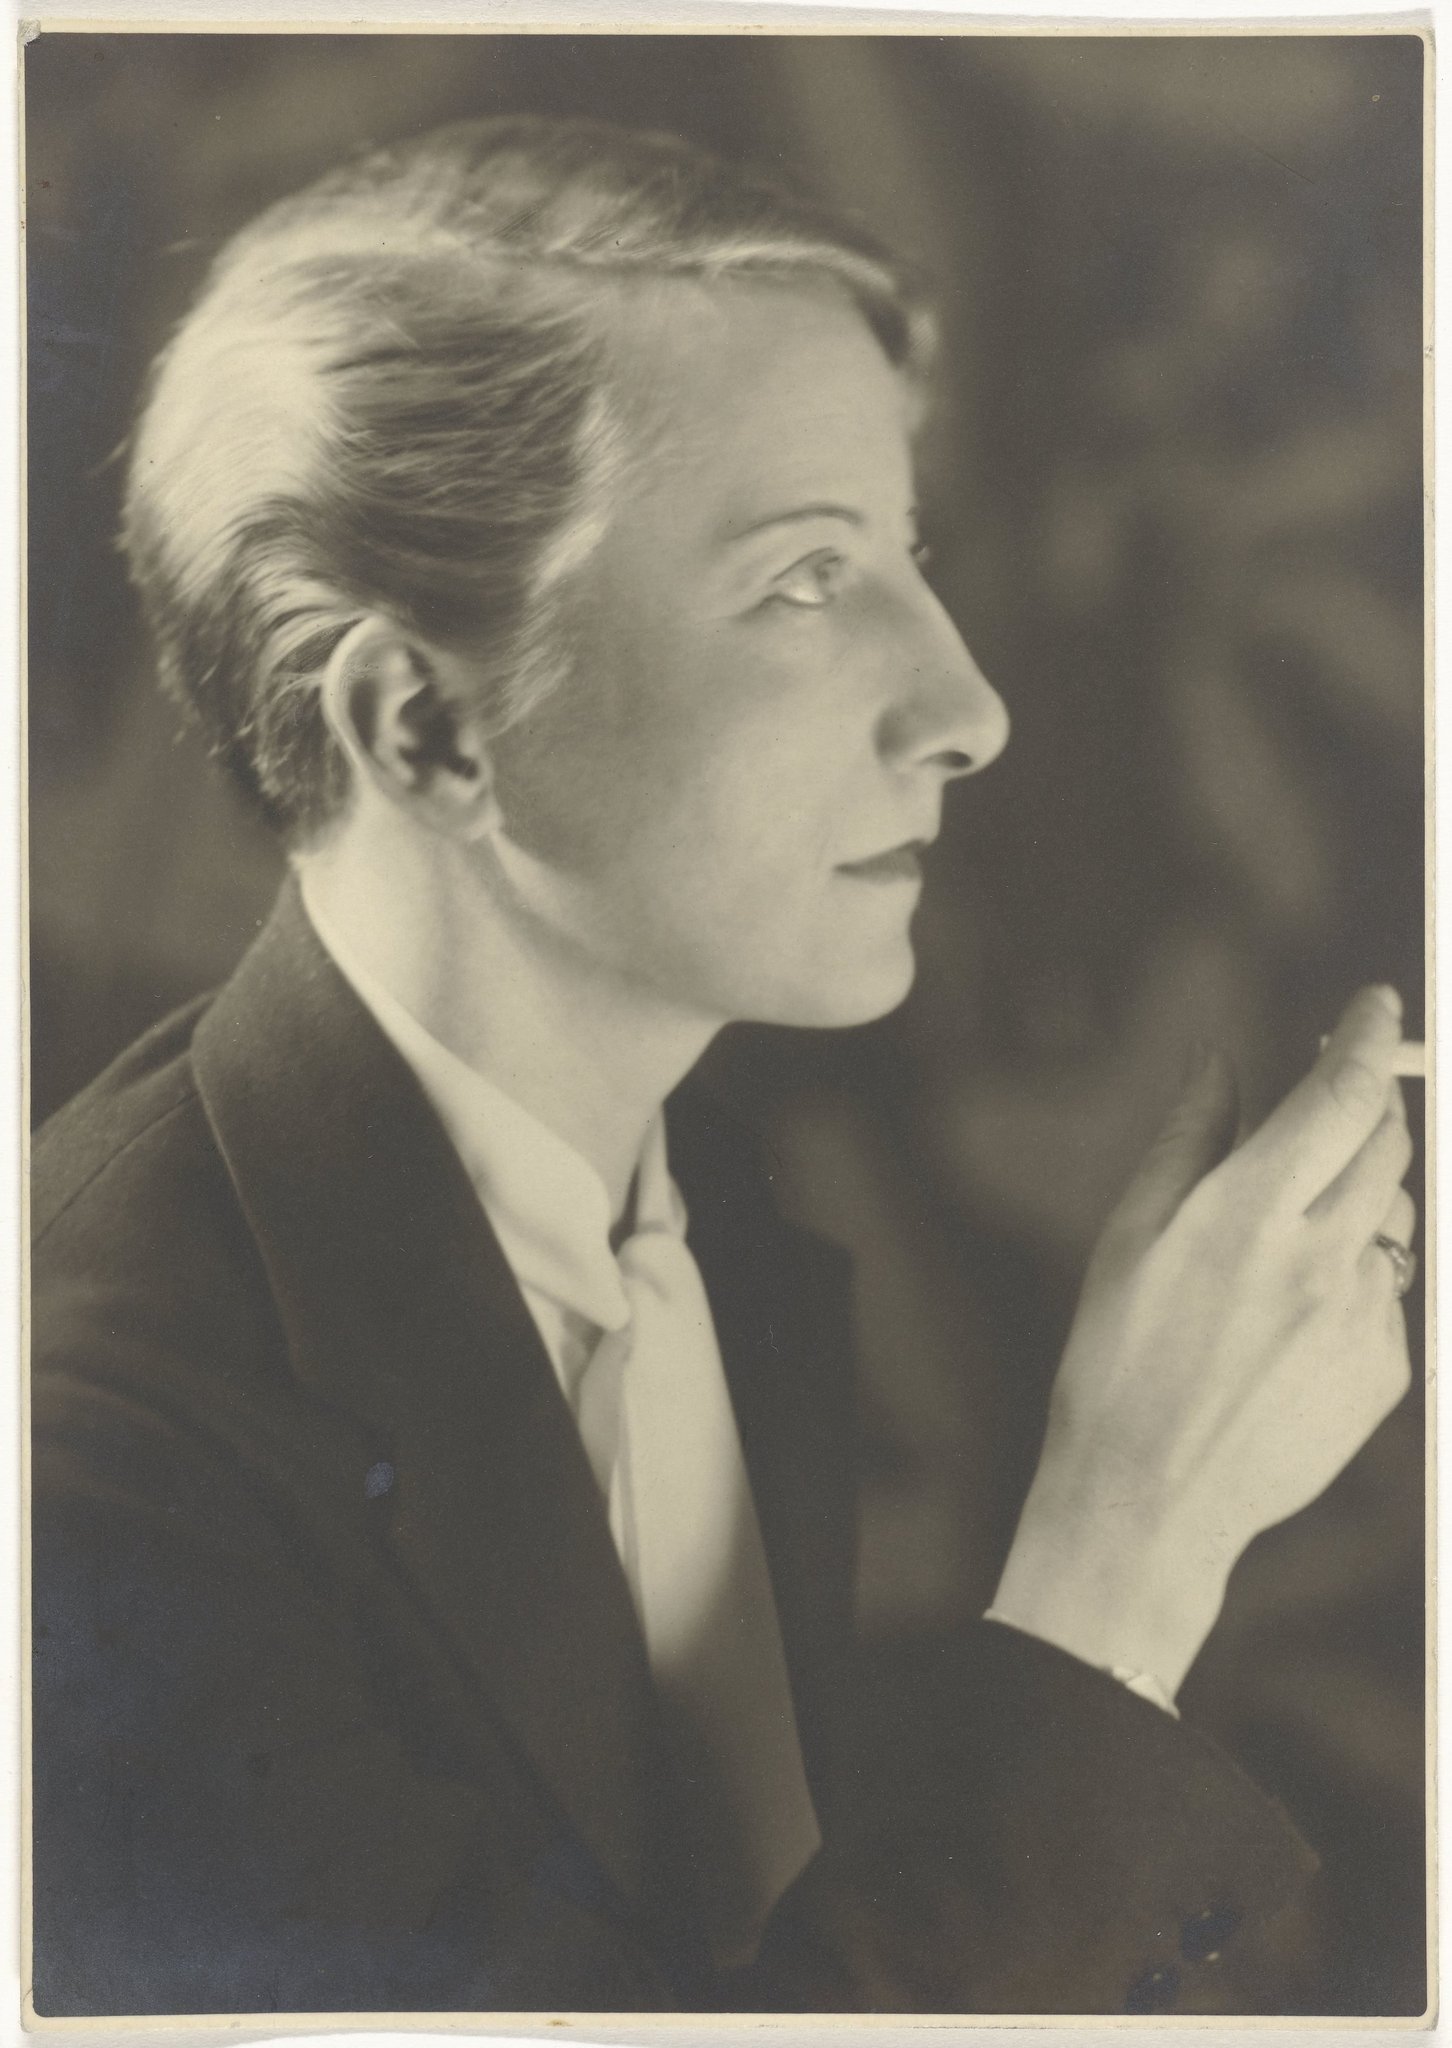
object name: photograph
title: Portret van Irene With-Sauer met sigaret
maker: Anonymous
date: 1920-1930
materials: paper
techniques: gelatin silver print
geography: germany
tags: adolescent, young woman, maiden, cigarette, anonymous historical person portrayed, germany